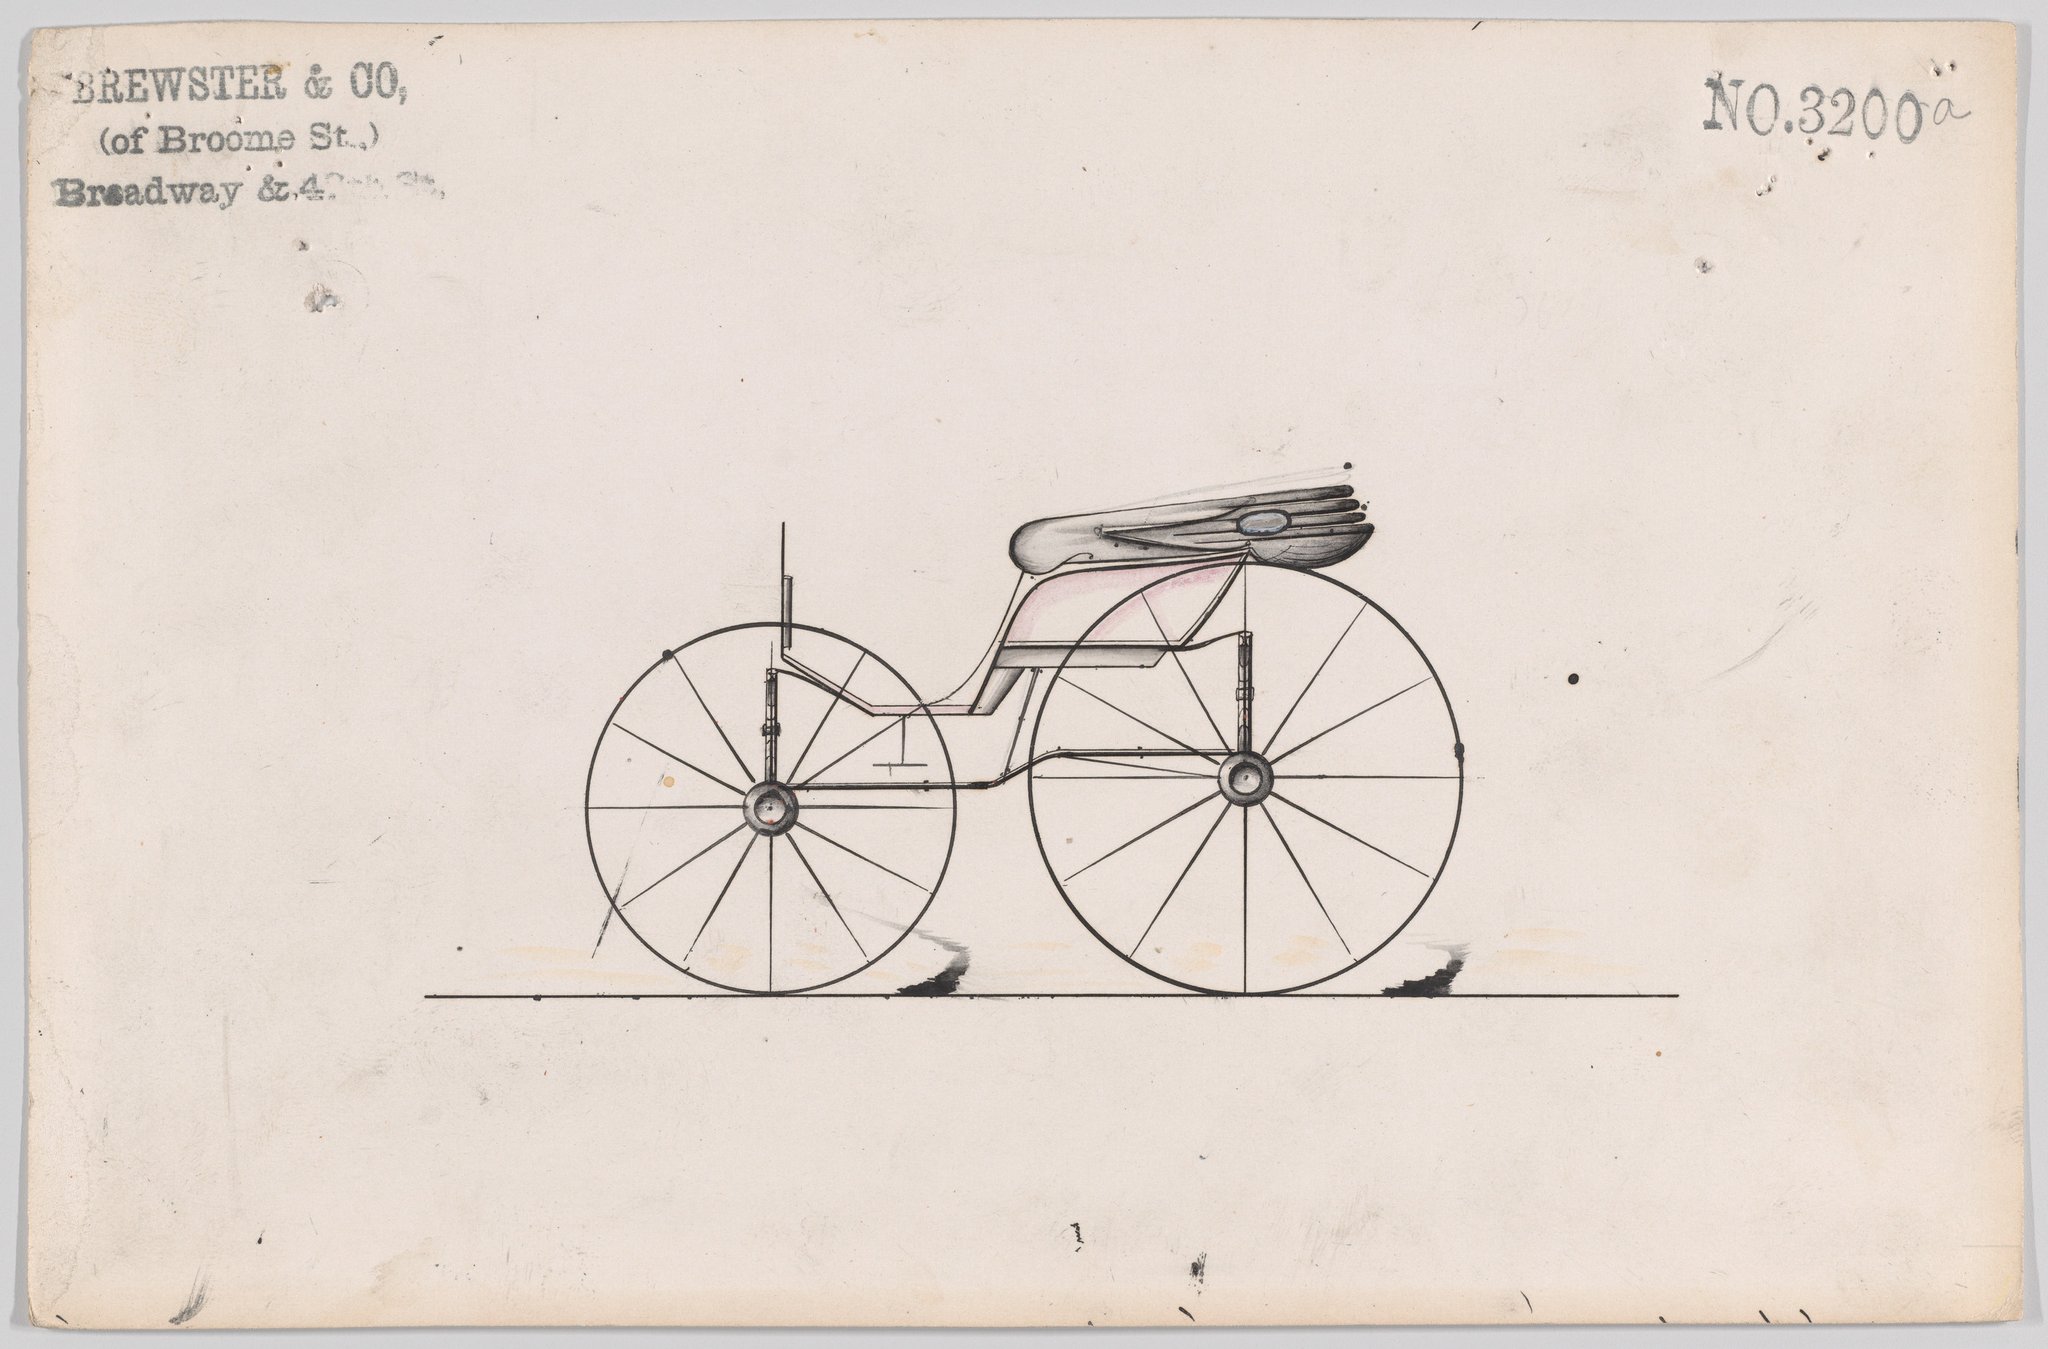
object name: drawing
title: Design for Pony Phaeton, no. 3200a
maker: brewster & co.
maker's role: manufacturer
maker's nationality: american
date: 1876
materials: ink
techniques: pen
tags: carriages